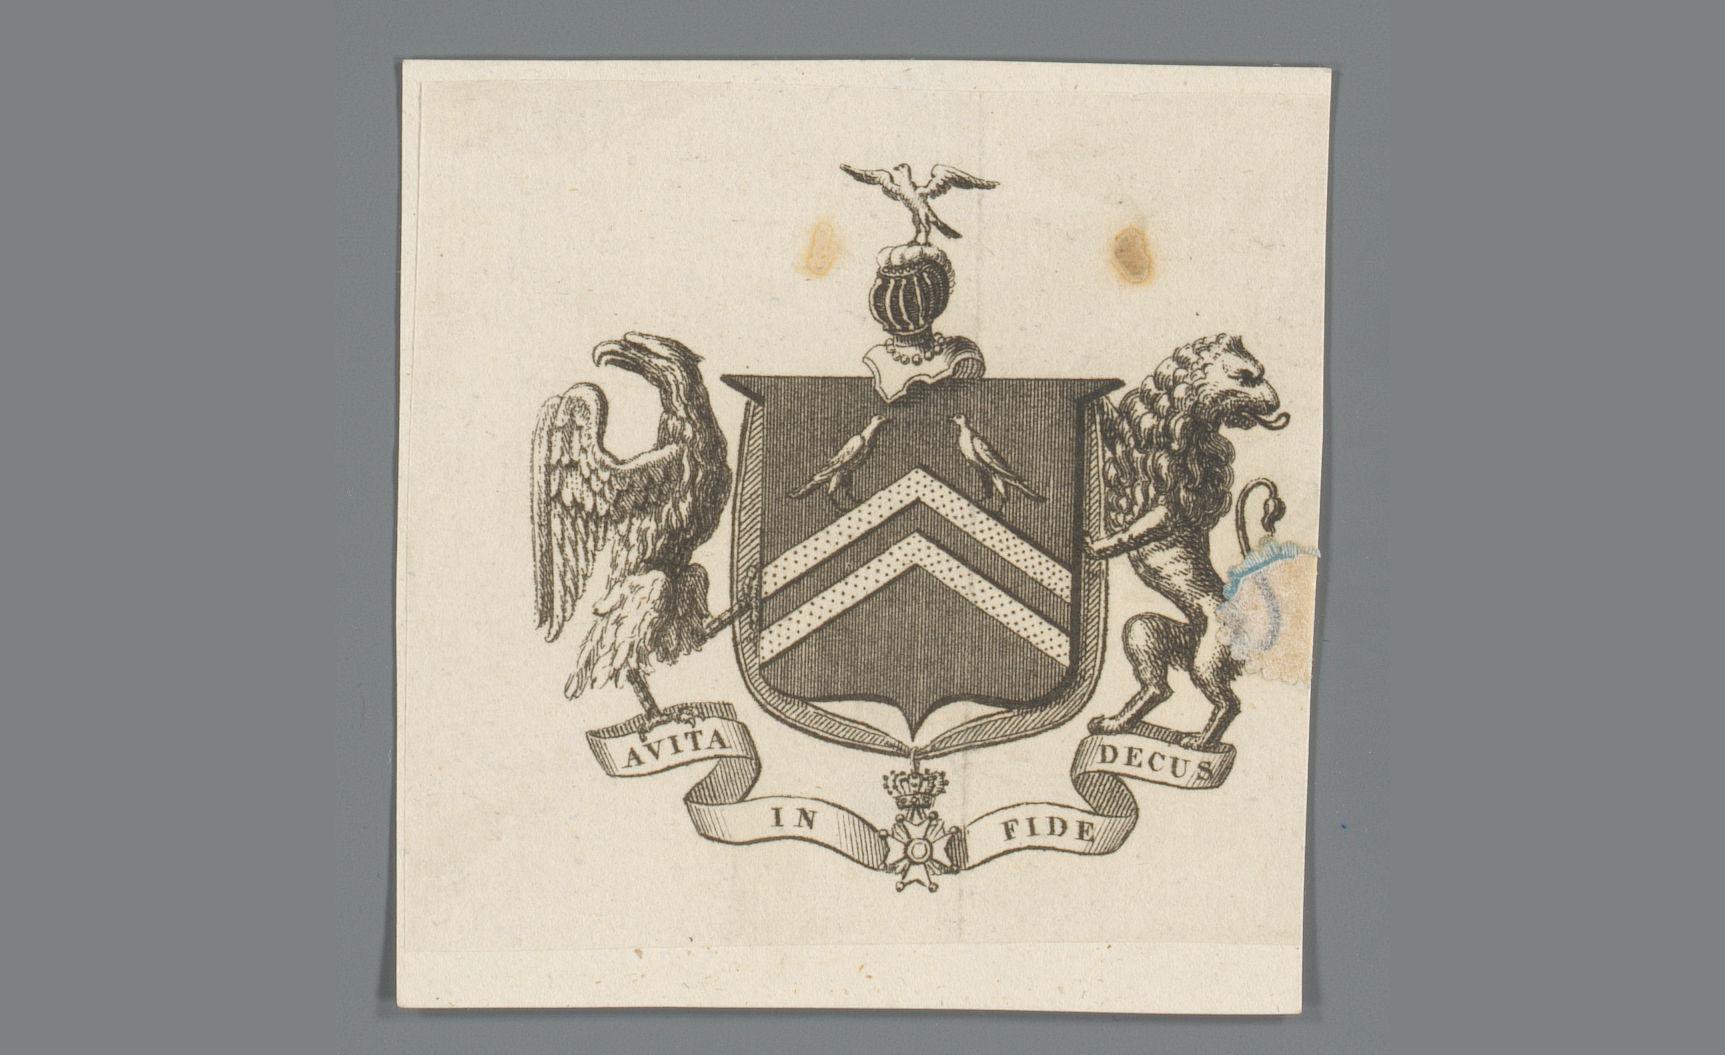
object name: print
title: Wapenschild van de familie Von Kleist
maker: Anonymous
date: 1700-1799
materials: paper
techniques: engraving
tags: armorial bearing, heraldry